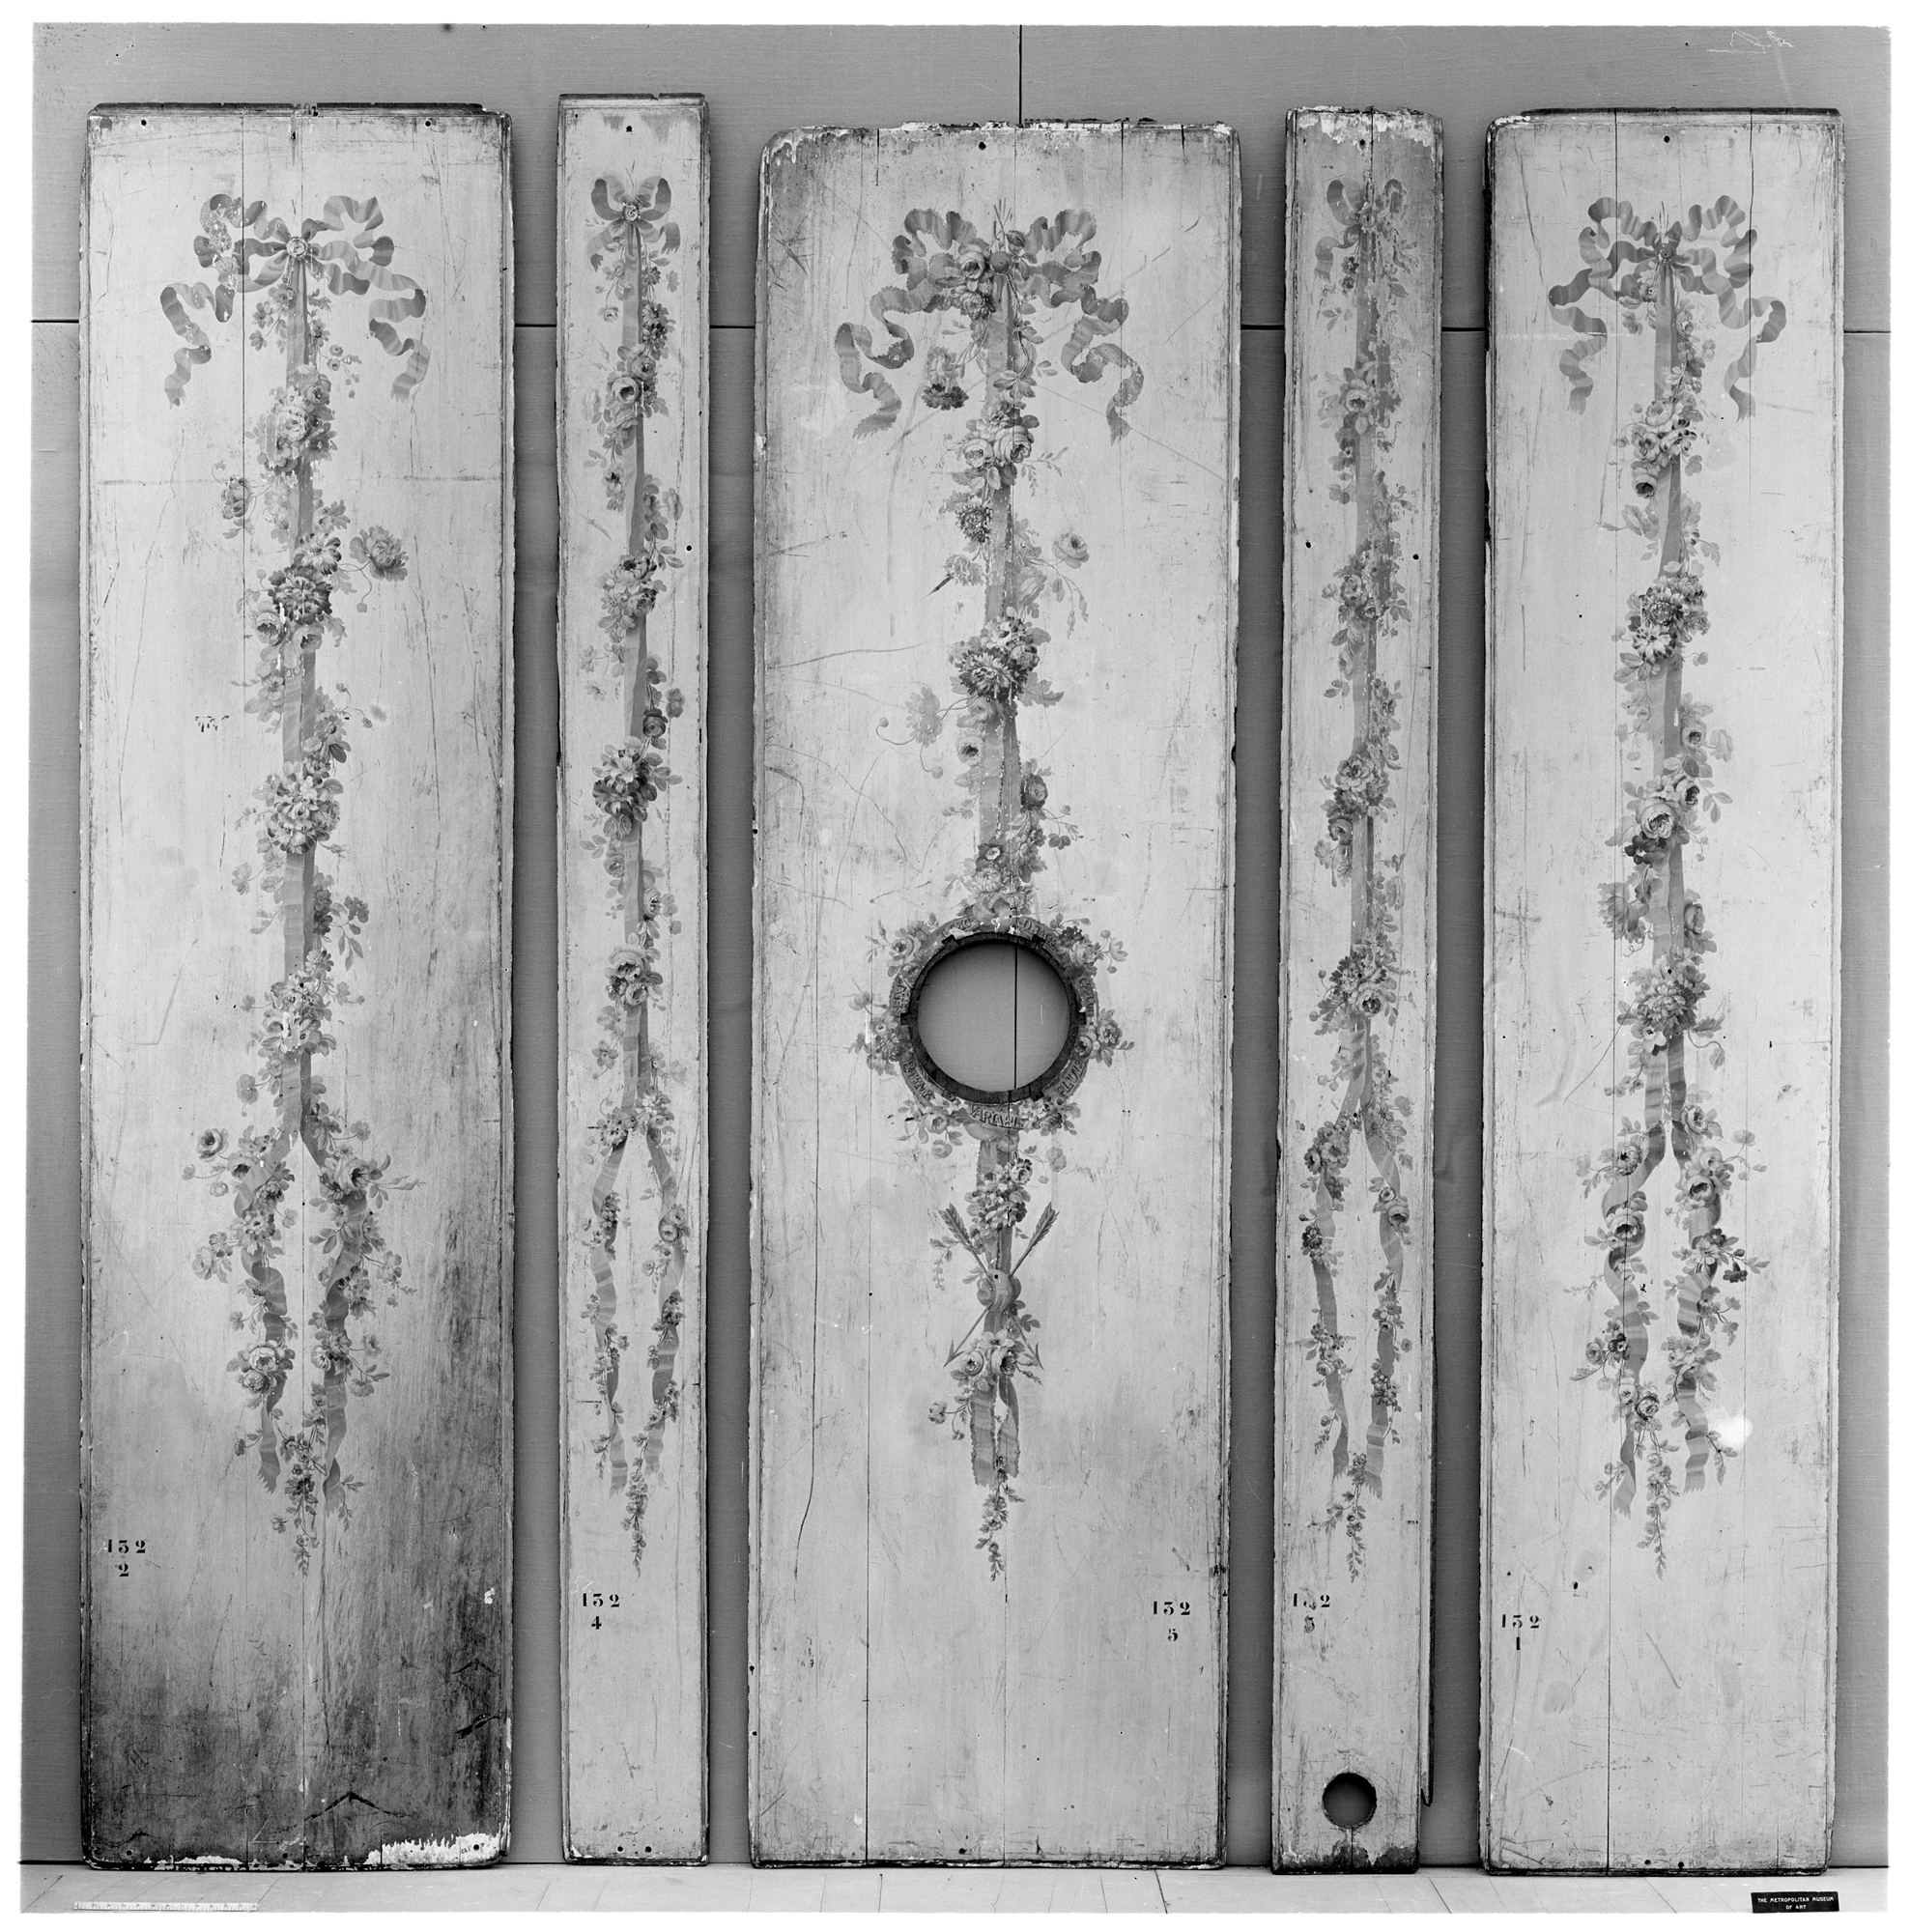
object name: panel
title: Set of five panels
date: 1760-1780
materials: wood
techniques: painting